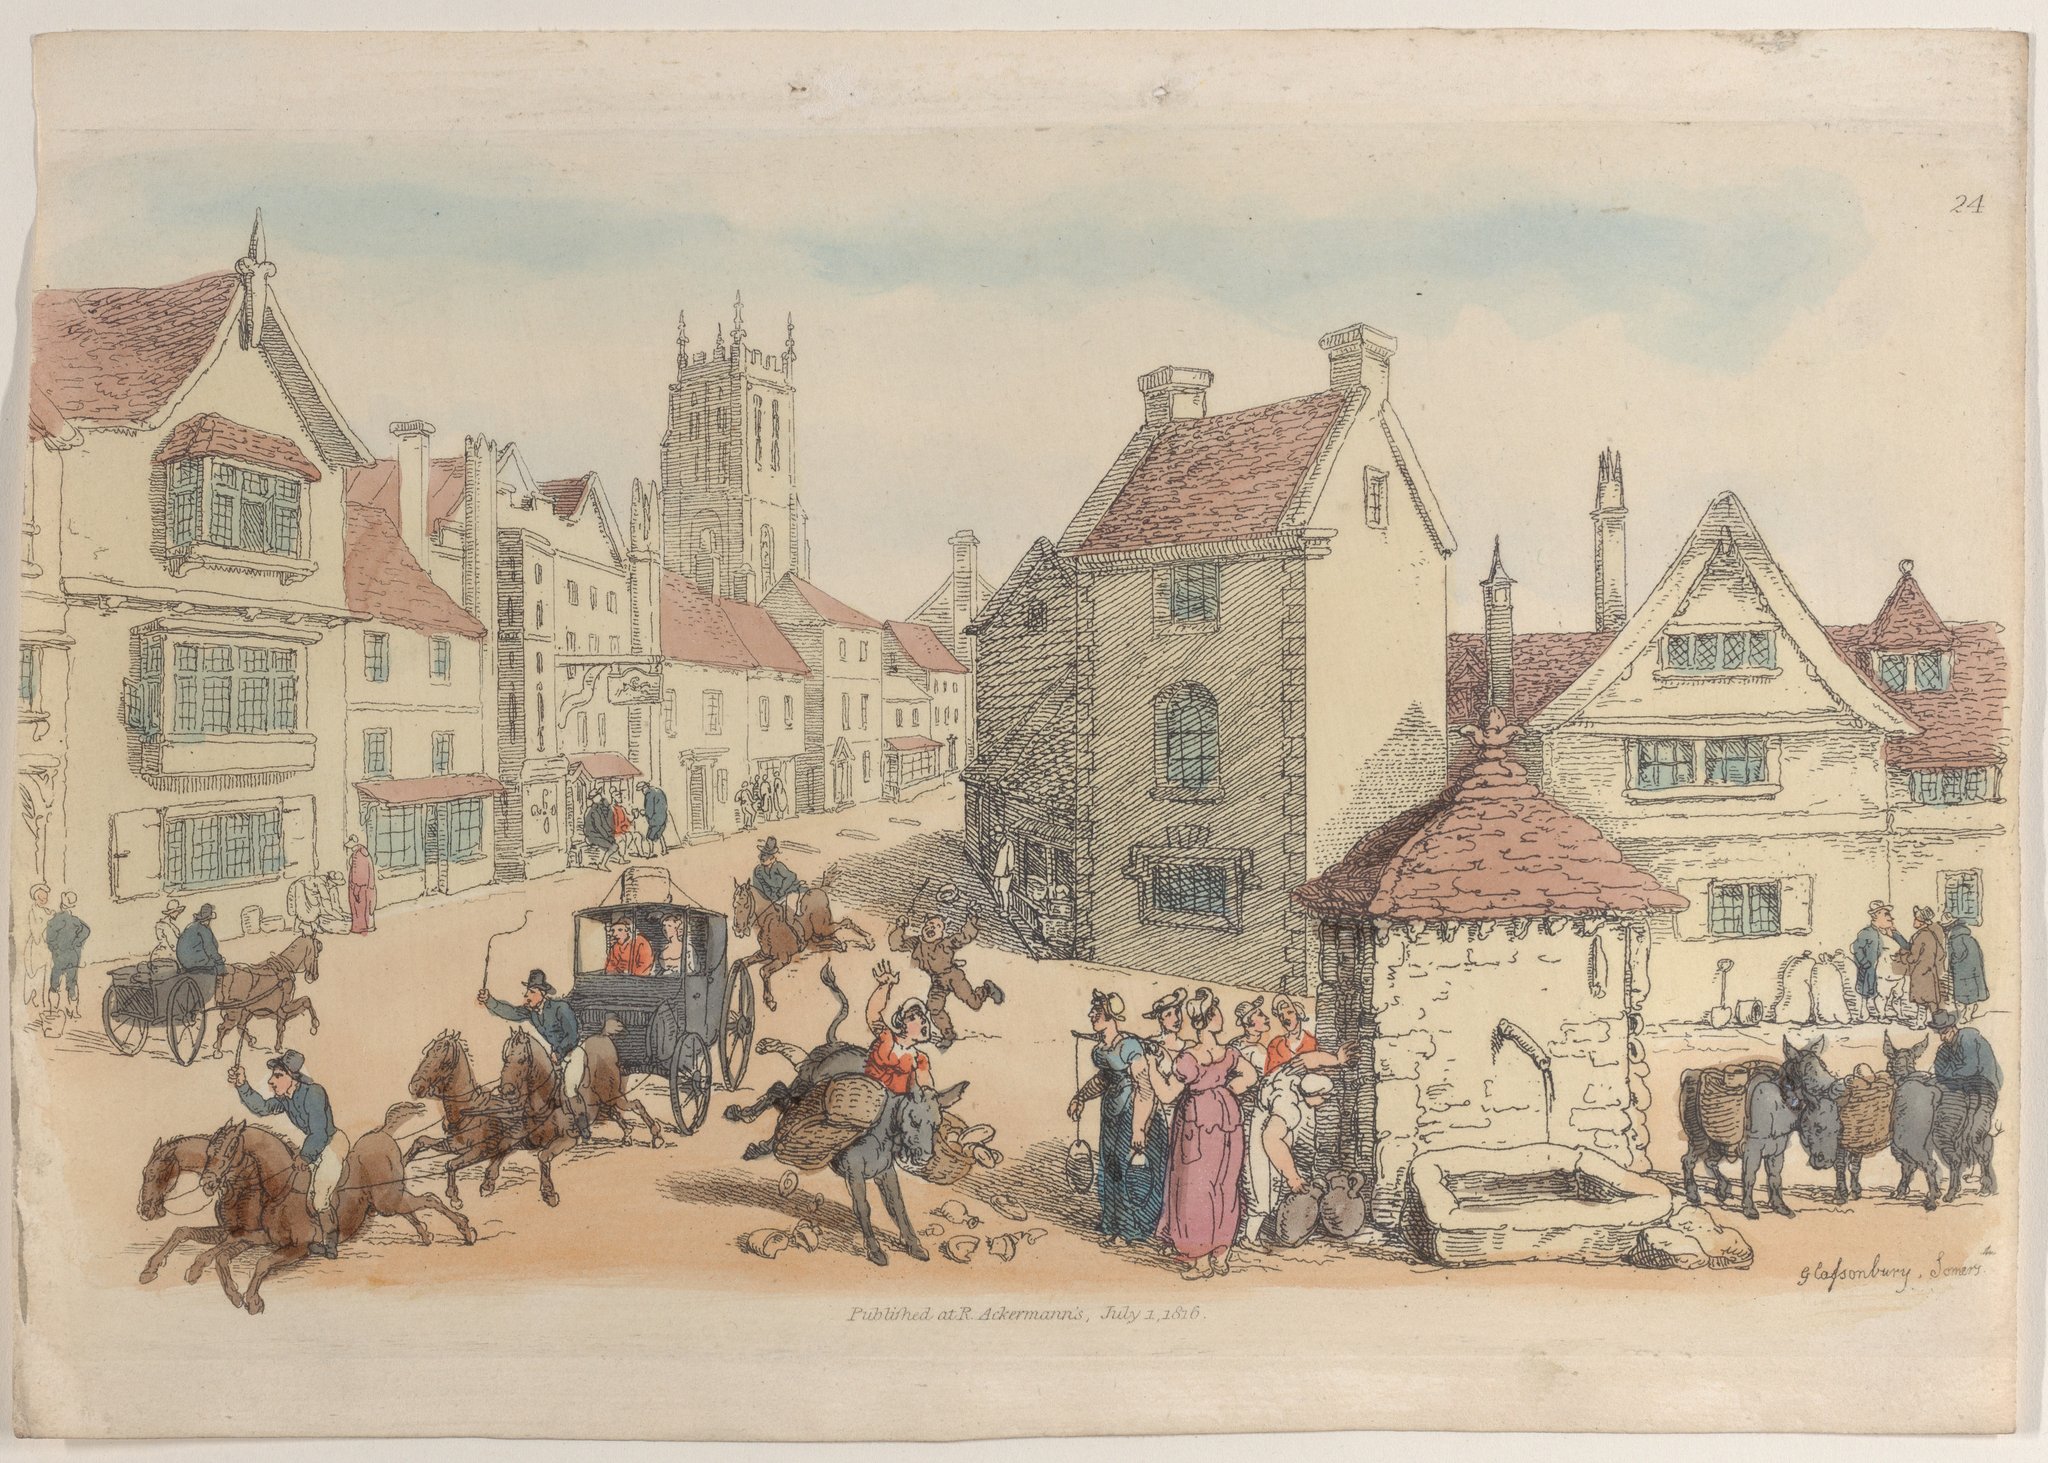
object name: print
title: Plate 24, from "World in Miniature"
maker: thomas rowlandson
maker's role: artist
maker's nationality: british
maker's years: 1757-1827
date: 1816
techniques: etching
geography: london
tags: towns,men,women,horses,carriages